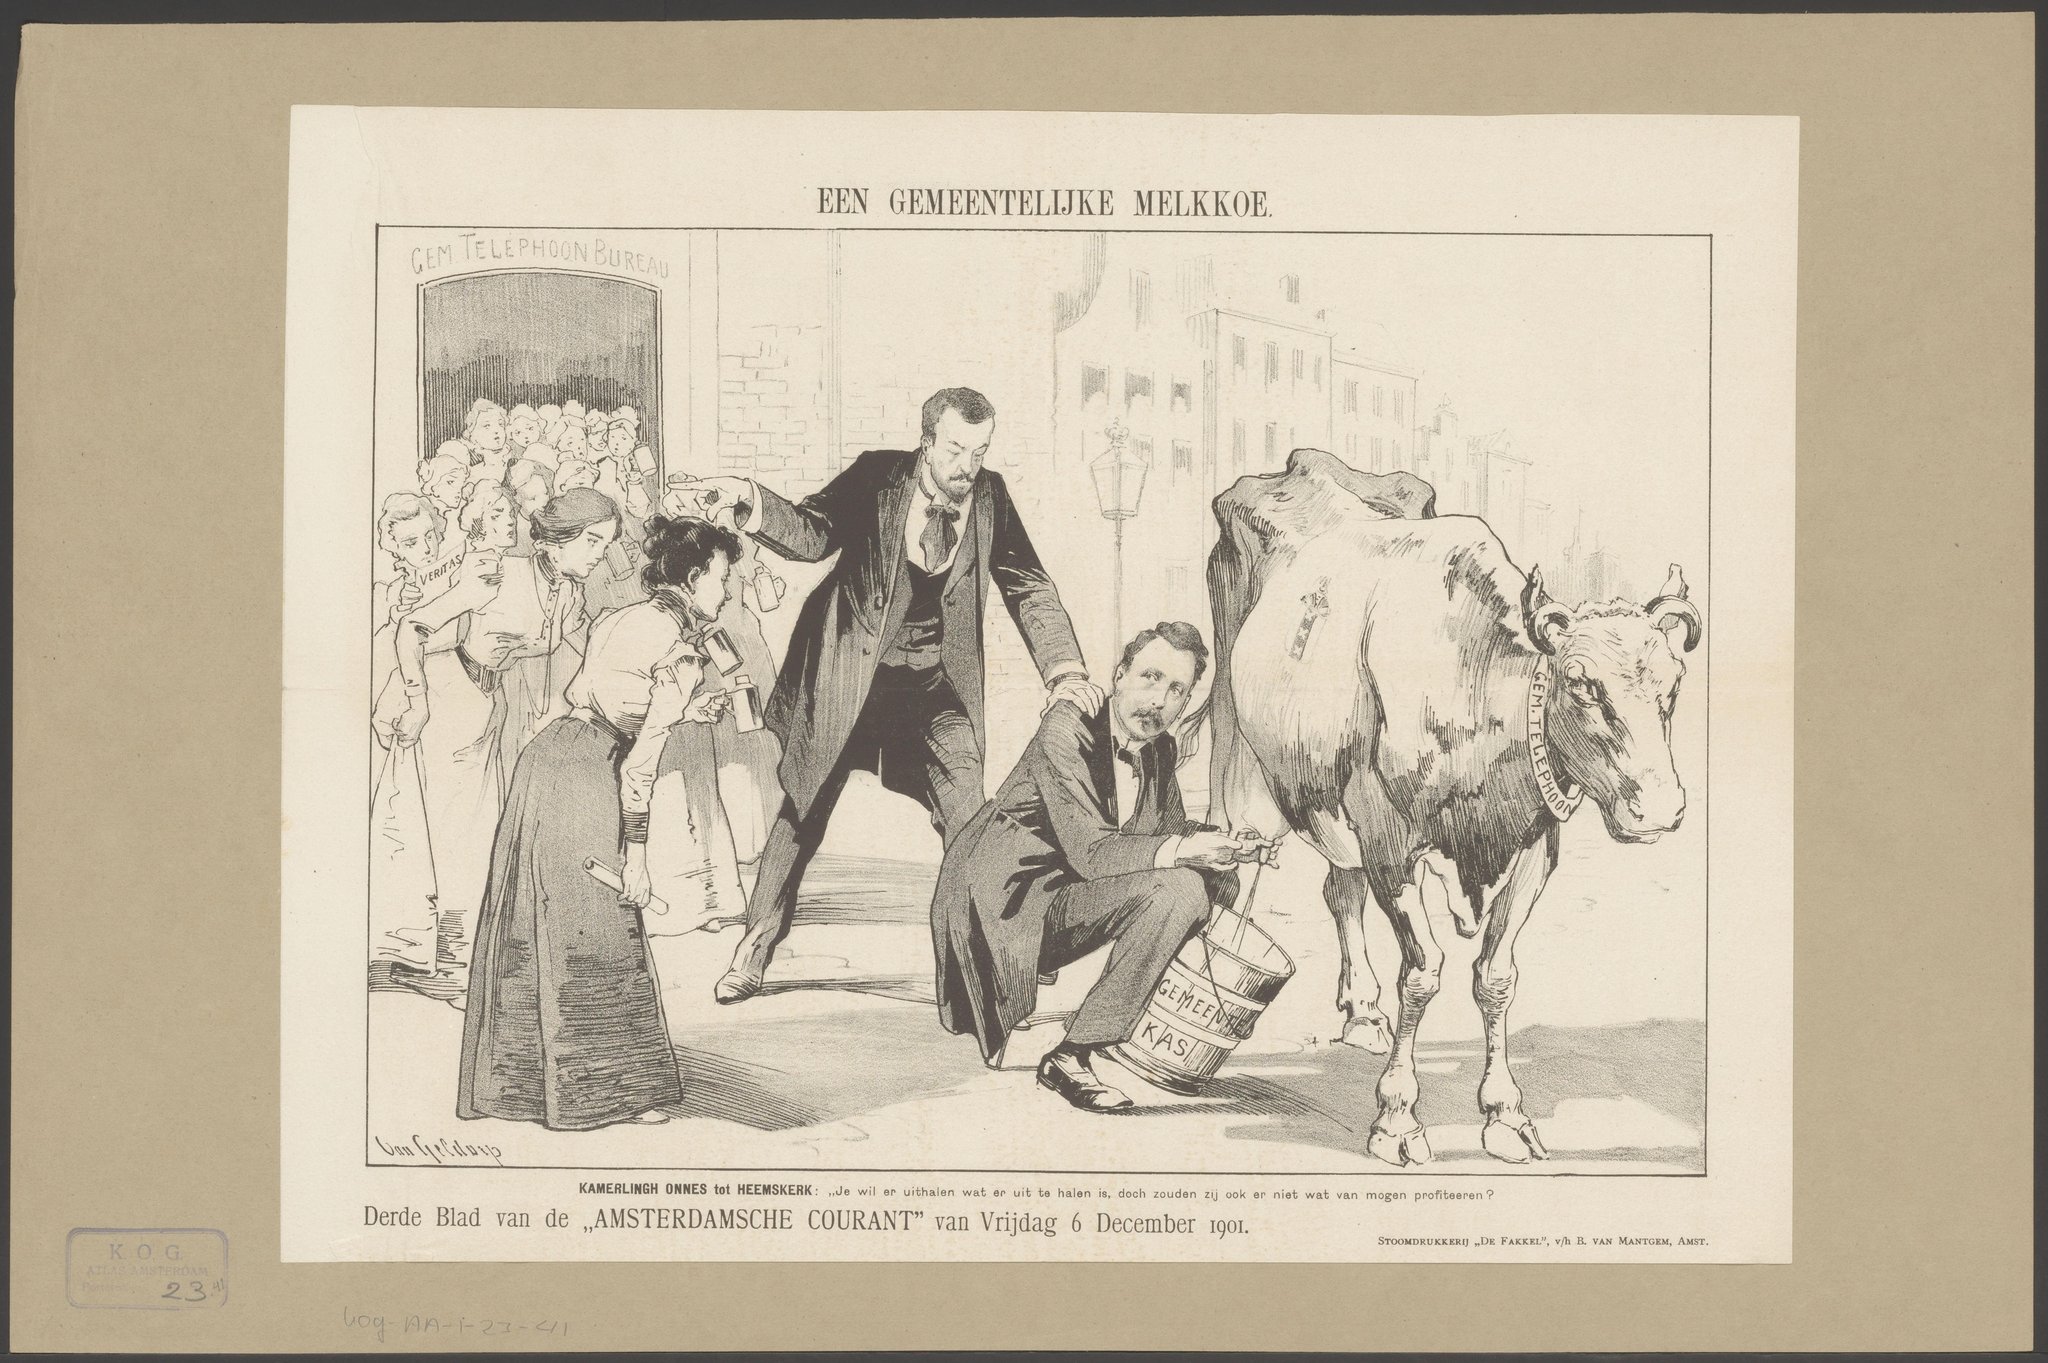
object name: cartoon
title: Heike Kamerlingh Onnes wijst naar telefonistes met collectebussen terwijl Theodorus Heemskerk een koe melkt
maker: petrus van geldorp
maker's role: draughtsman, print maker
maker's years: 1872-1939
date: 1901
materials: paper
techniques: letterpress printing, lithograph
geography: amsterdam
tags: amsterdam, utrecht, cow, offertory-box, offertory-bag, milking, political caricatures and satires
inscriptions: collector's mark: Lugt 1641b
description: De koe is gebrandmerkt met het wapen van Amsterdam en draagt een halsband waarop 'Gem. telephoon' te lezen staat. Haar melk komt terecht in een emmer waarop 'Gemeentekas' te lezen staat. Onderwerpsrubriek binnen de Atlas Amsterdam: Gemeentebedrijven.